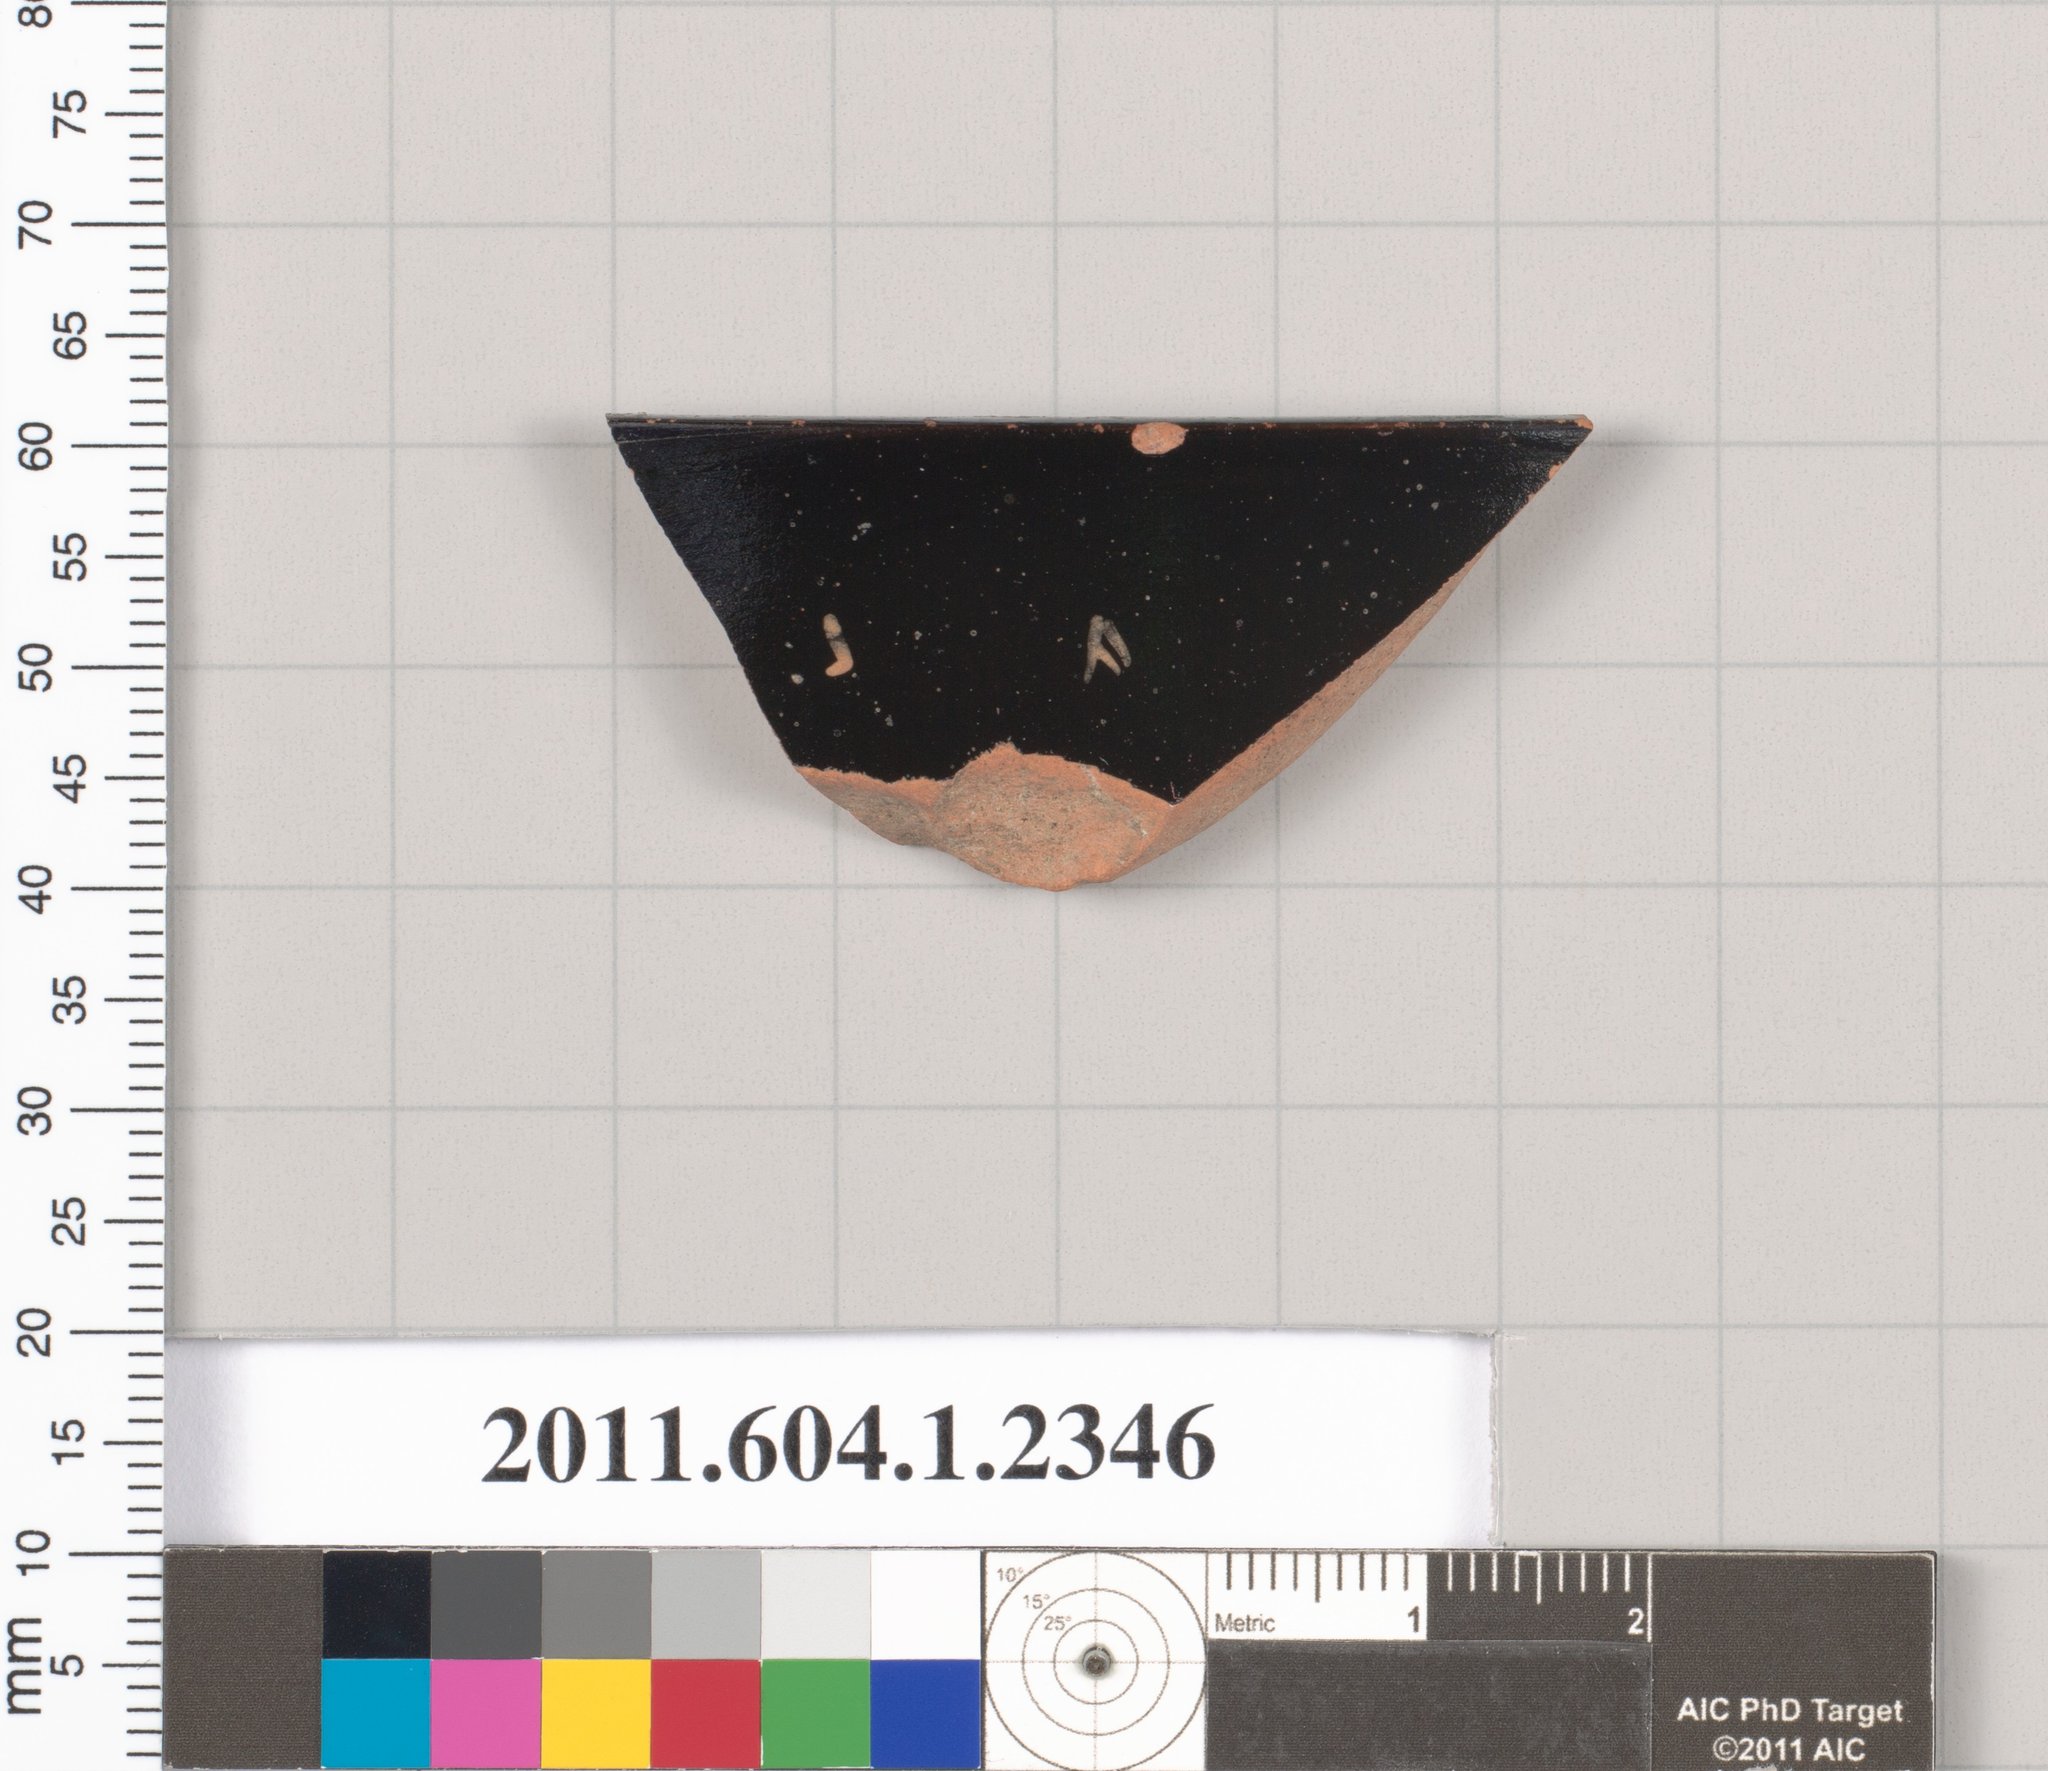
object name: kylix fragment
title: Terracotta rim fragment of a kylix (drinking cup)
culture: greek, attic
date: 534-468 BCE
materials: terracotta